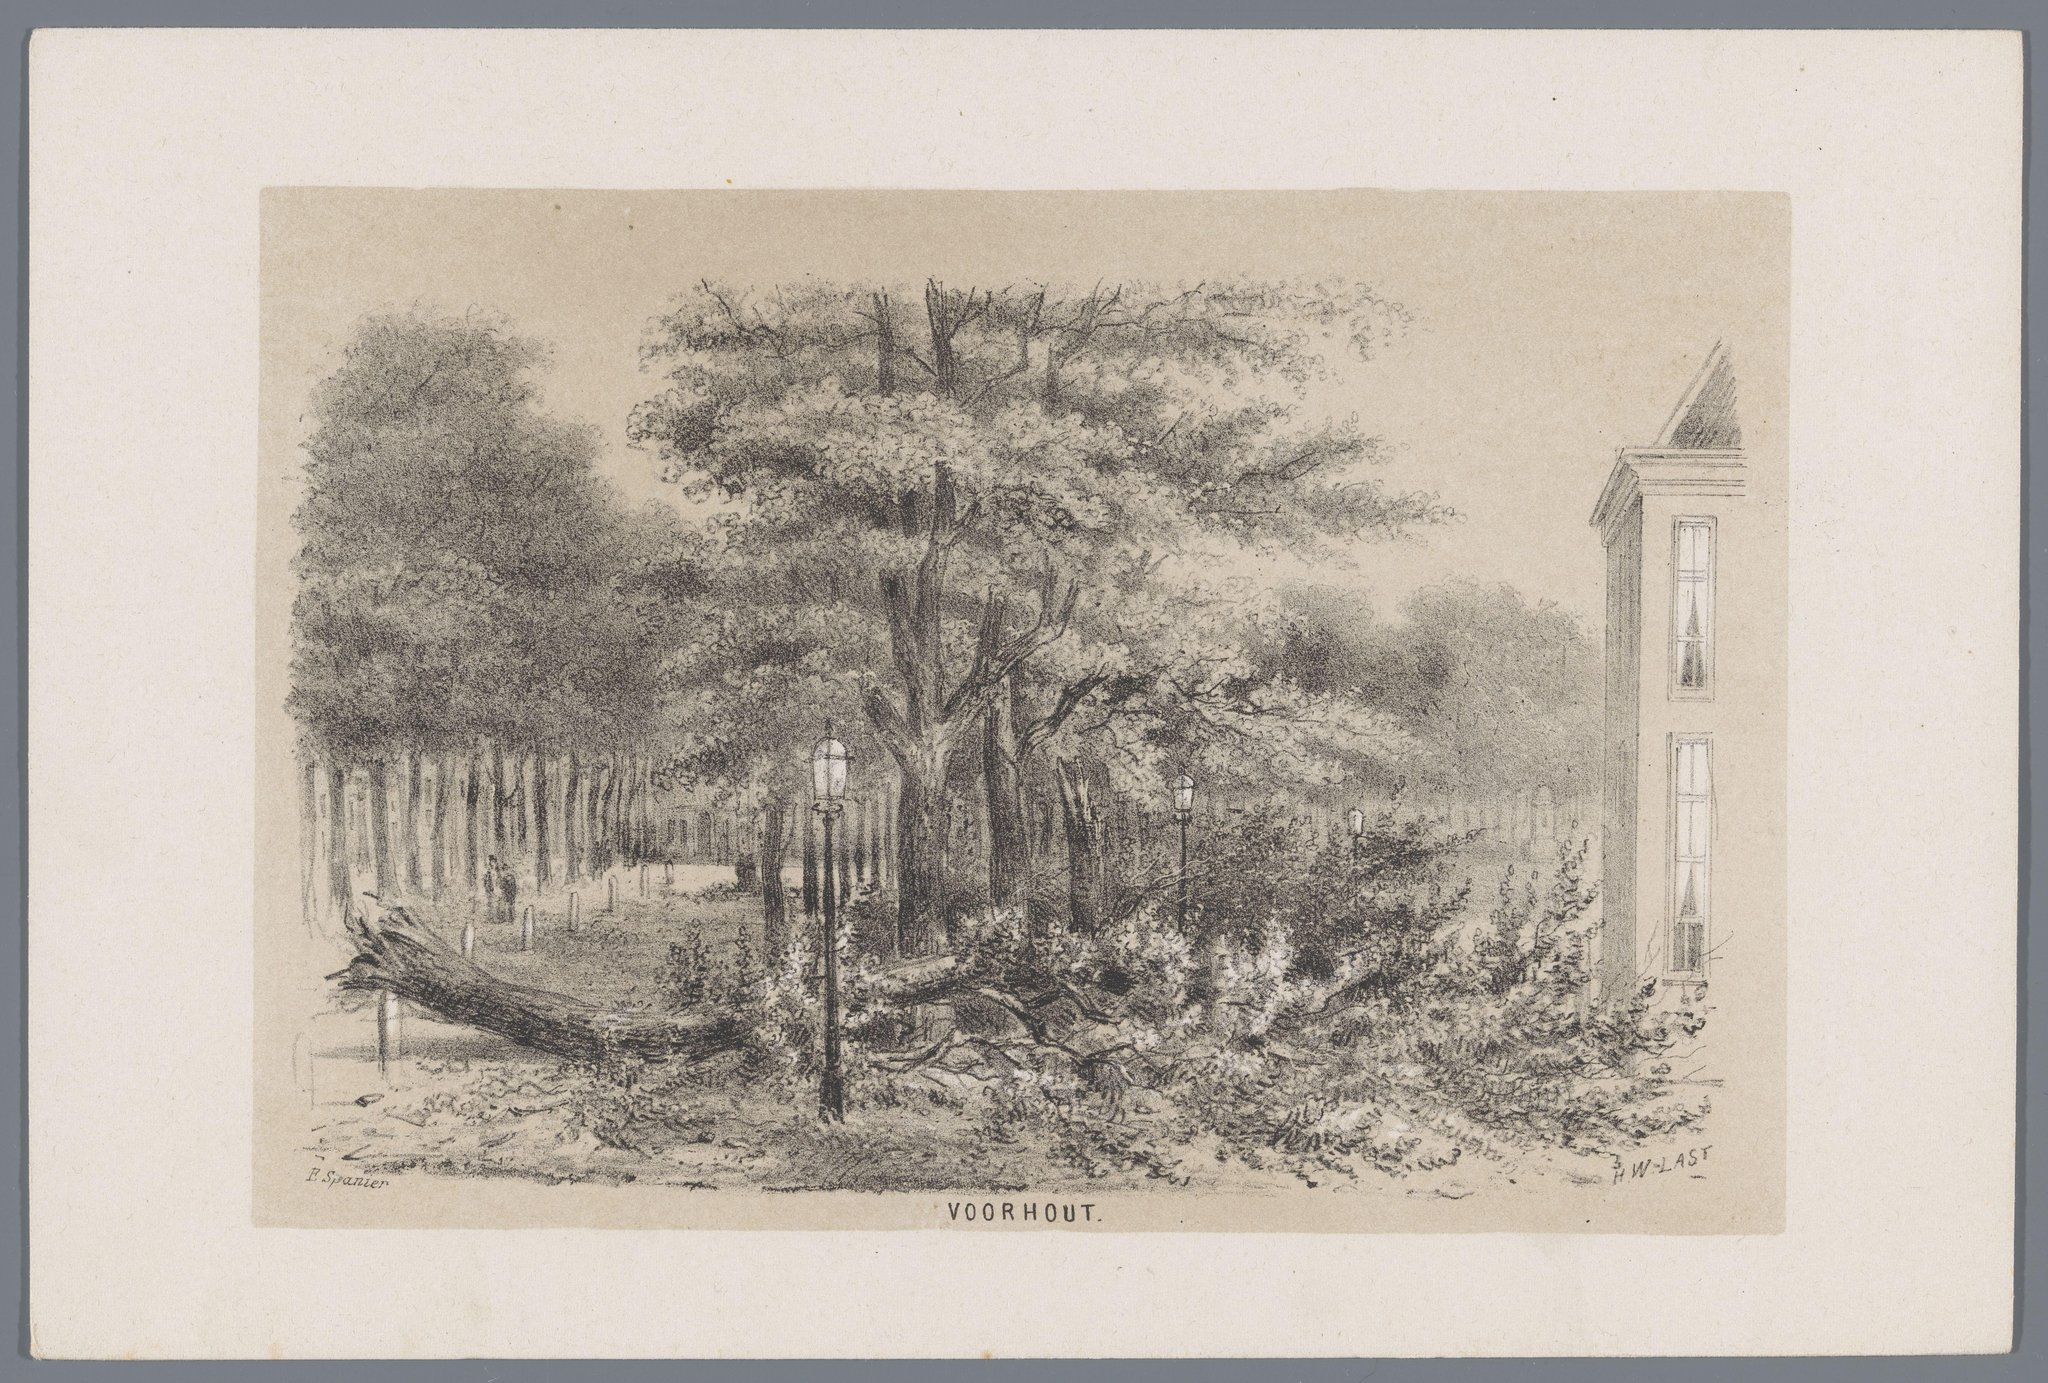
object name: print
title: Omgewaaide boom bij Voorhout, na de storm van 28 mei 1860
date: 1860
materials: paper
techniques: tone lithography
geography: netherlands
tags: storm on land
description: Een omgewaaide boom bij Voorhout, na de storm. Onderdeel van het album met tien losse steendrukken in een papieren omslag met voorstellingen van de schade aangericht door de 'Pinksterstorm' van 28 mei 1860 in het Haagse Bos en omgeving.